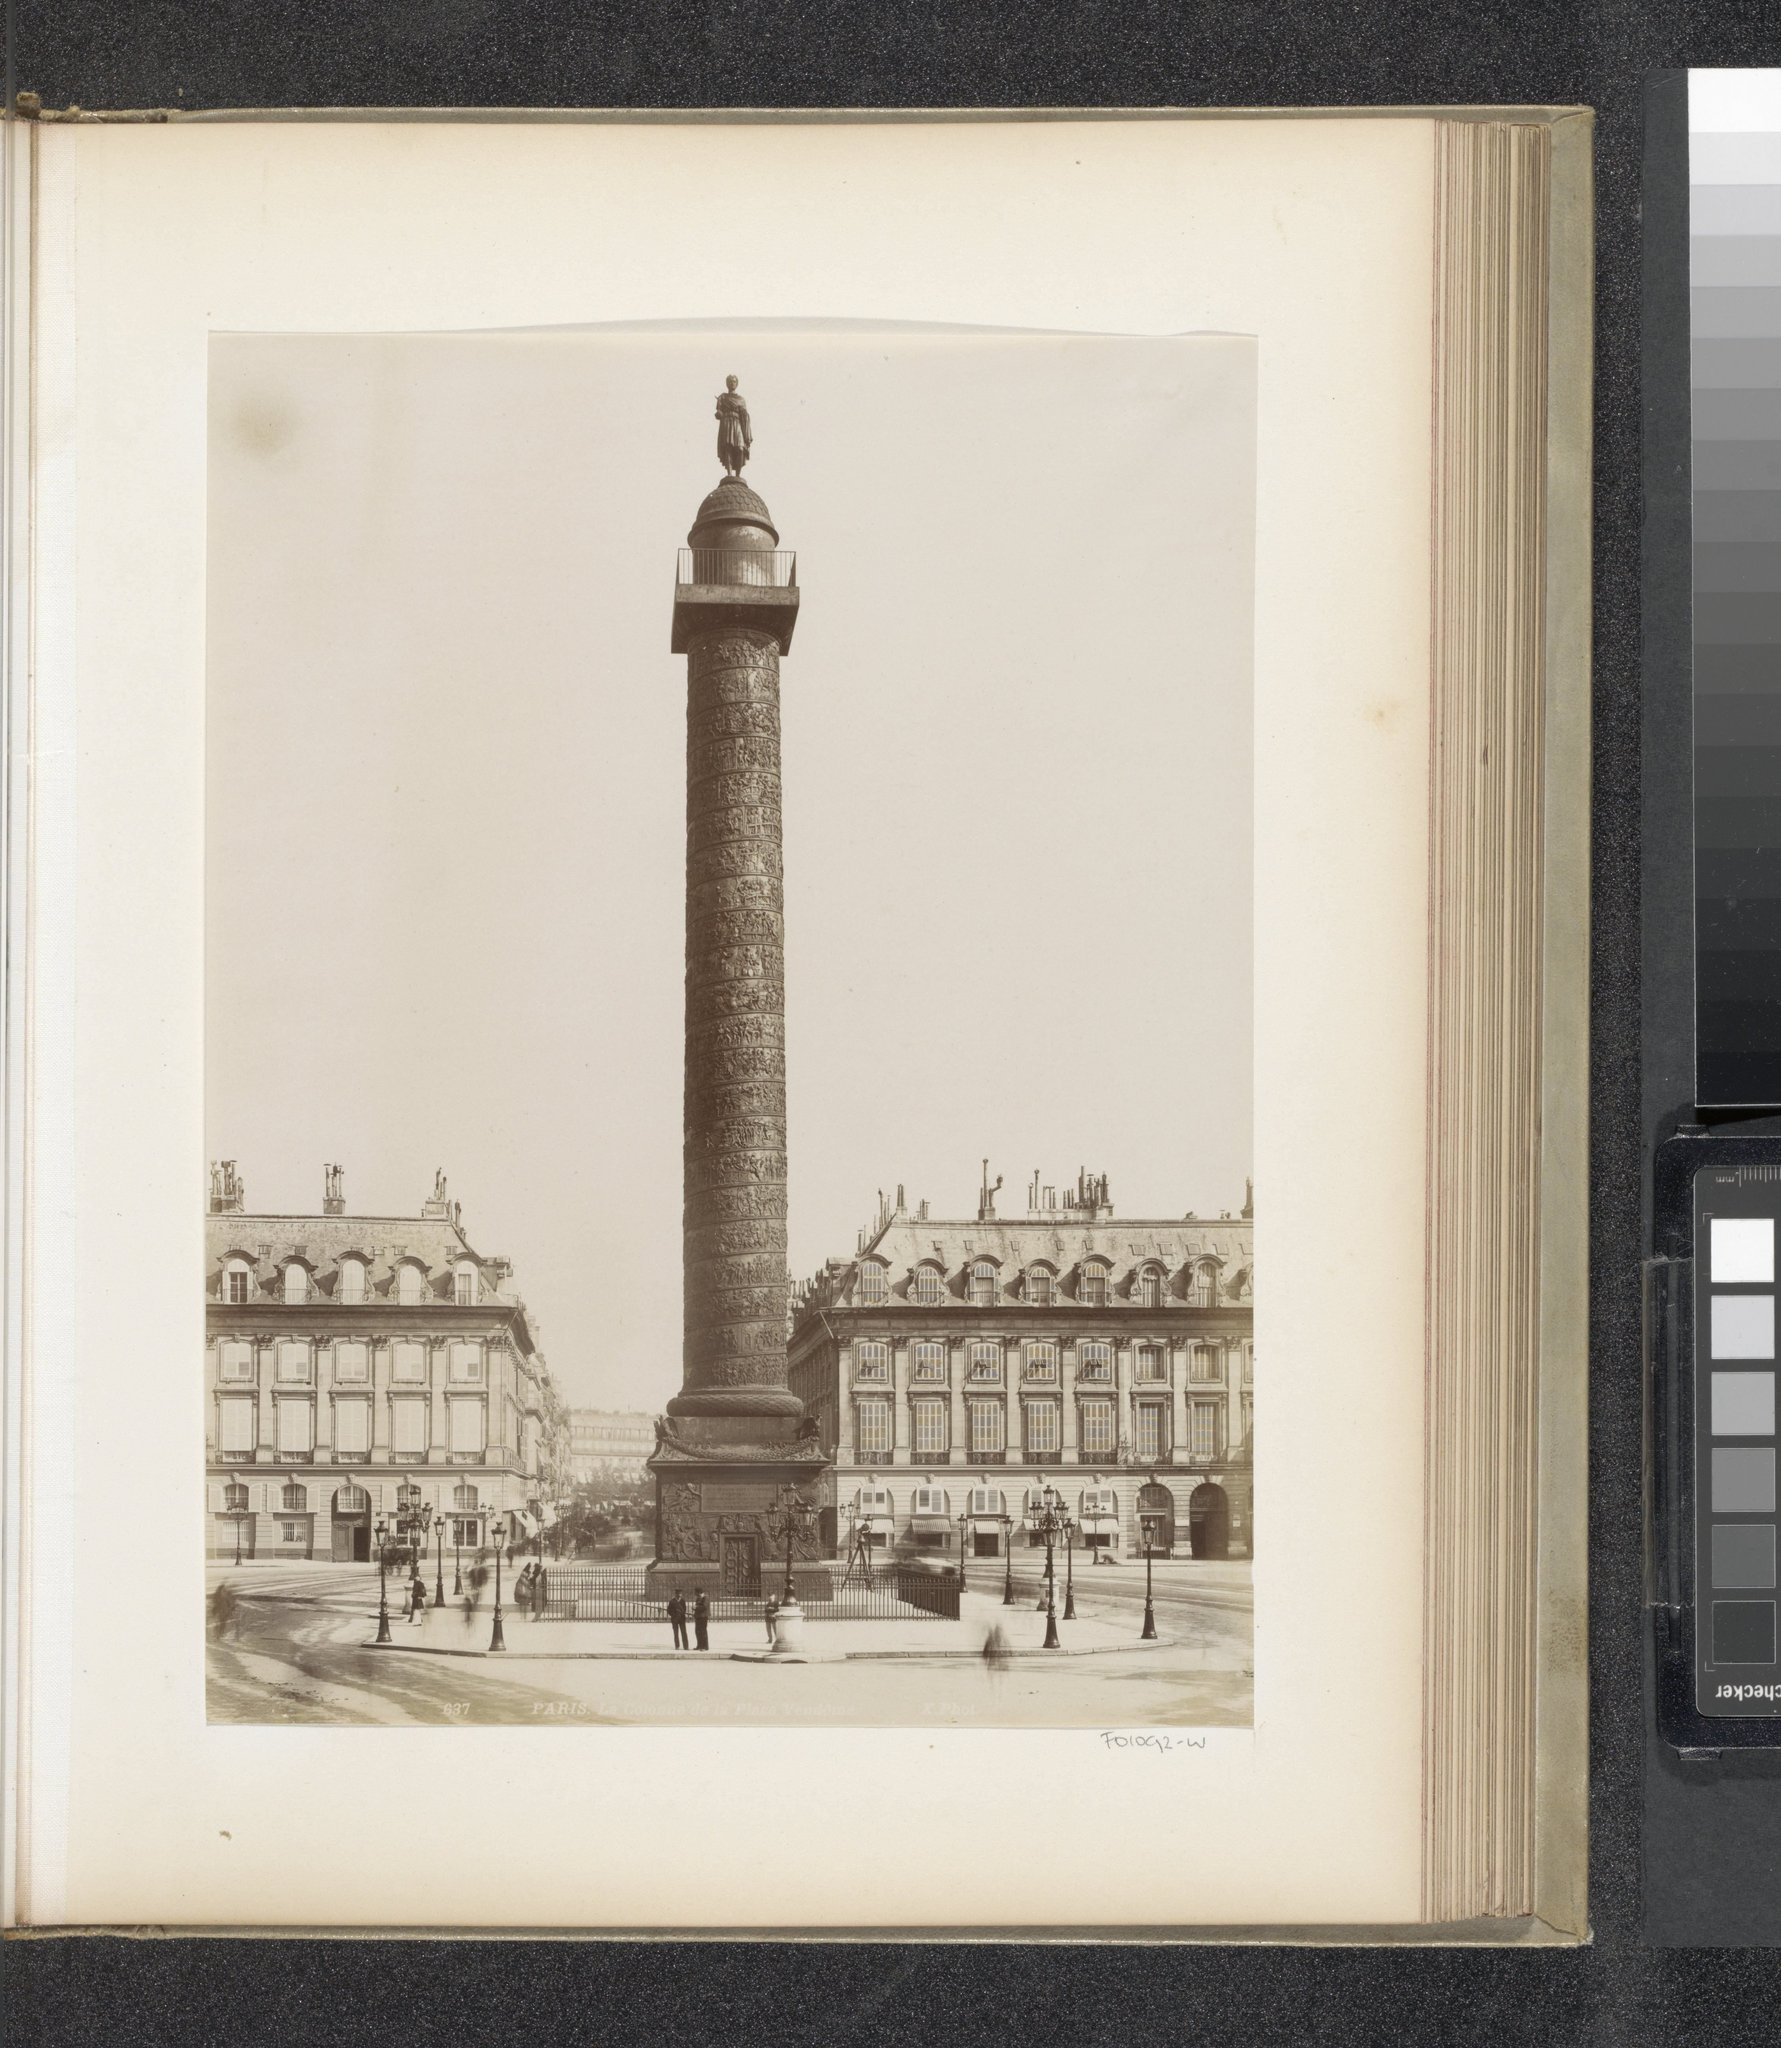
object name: photograph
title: PARIS. La Colonne de la Place Vendôme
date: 1880-1900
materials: cardboard, paper, photographic support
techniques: albumen print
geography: paris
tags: triumphal column with helical friezes (+ variant), square, place, circus, etc. (+ city(-scape) with figures, staffage)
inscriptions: negative number: ‘637’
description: Onderdeel van Reisalbum met foto's van bezienswaardigheden in België en Frankrijk.